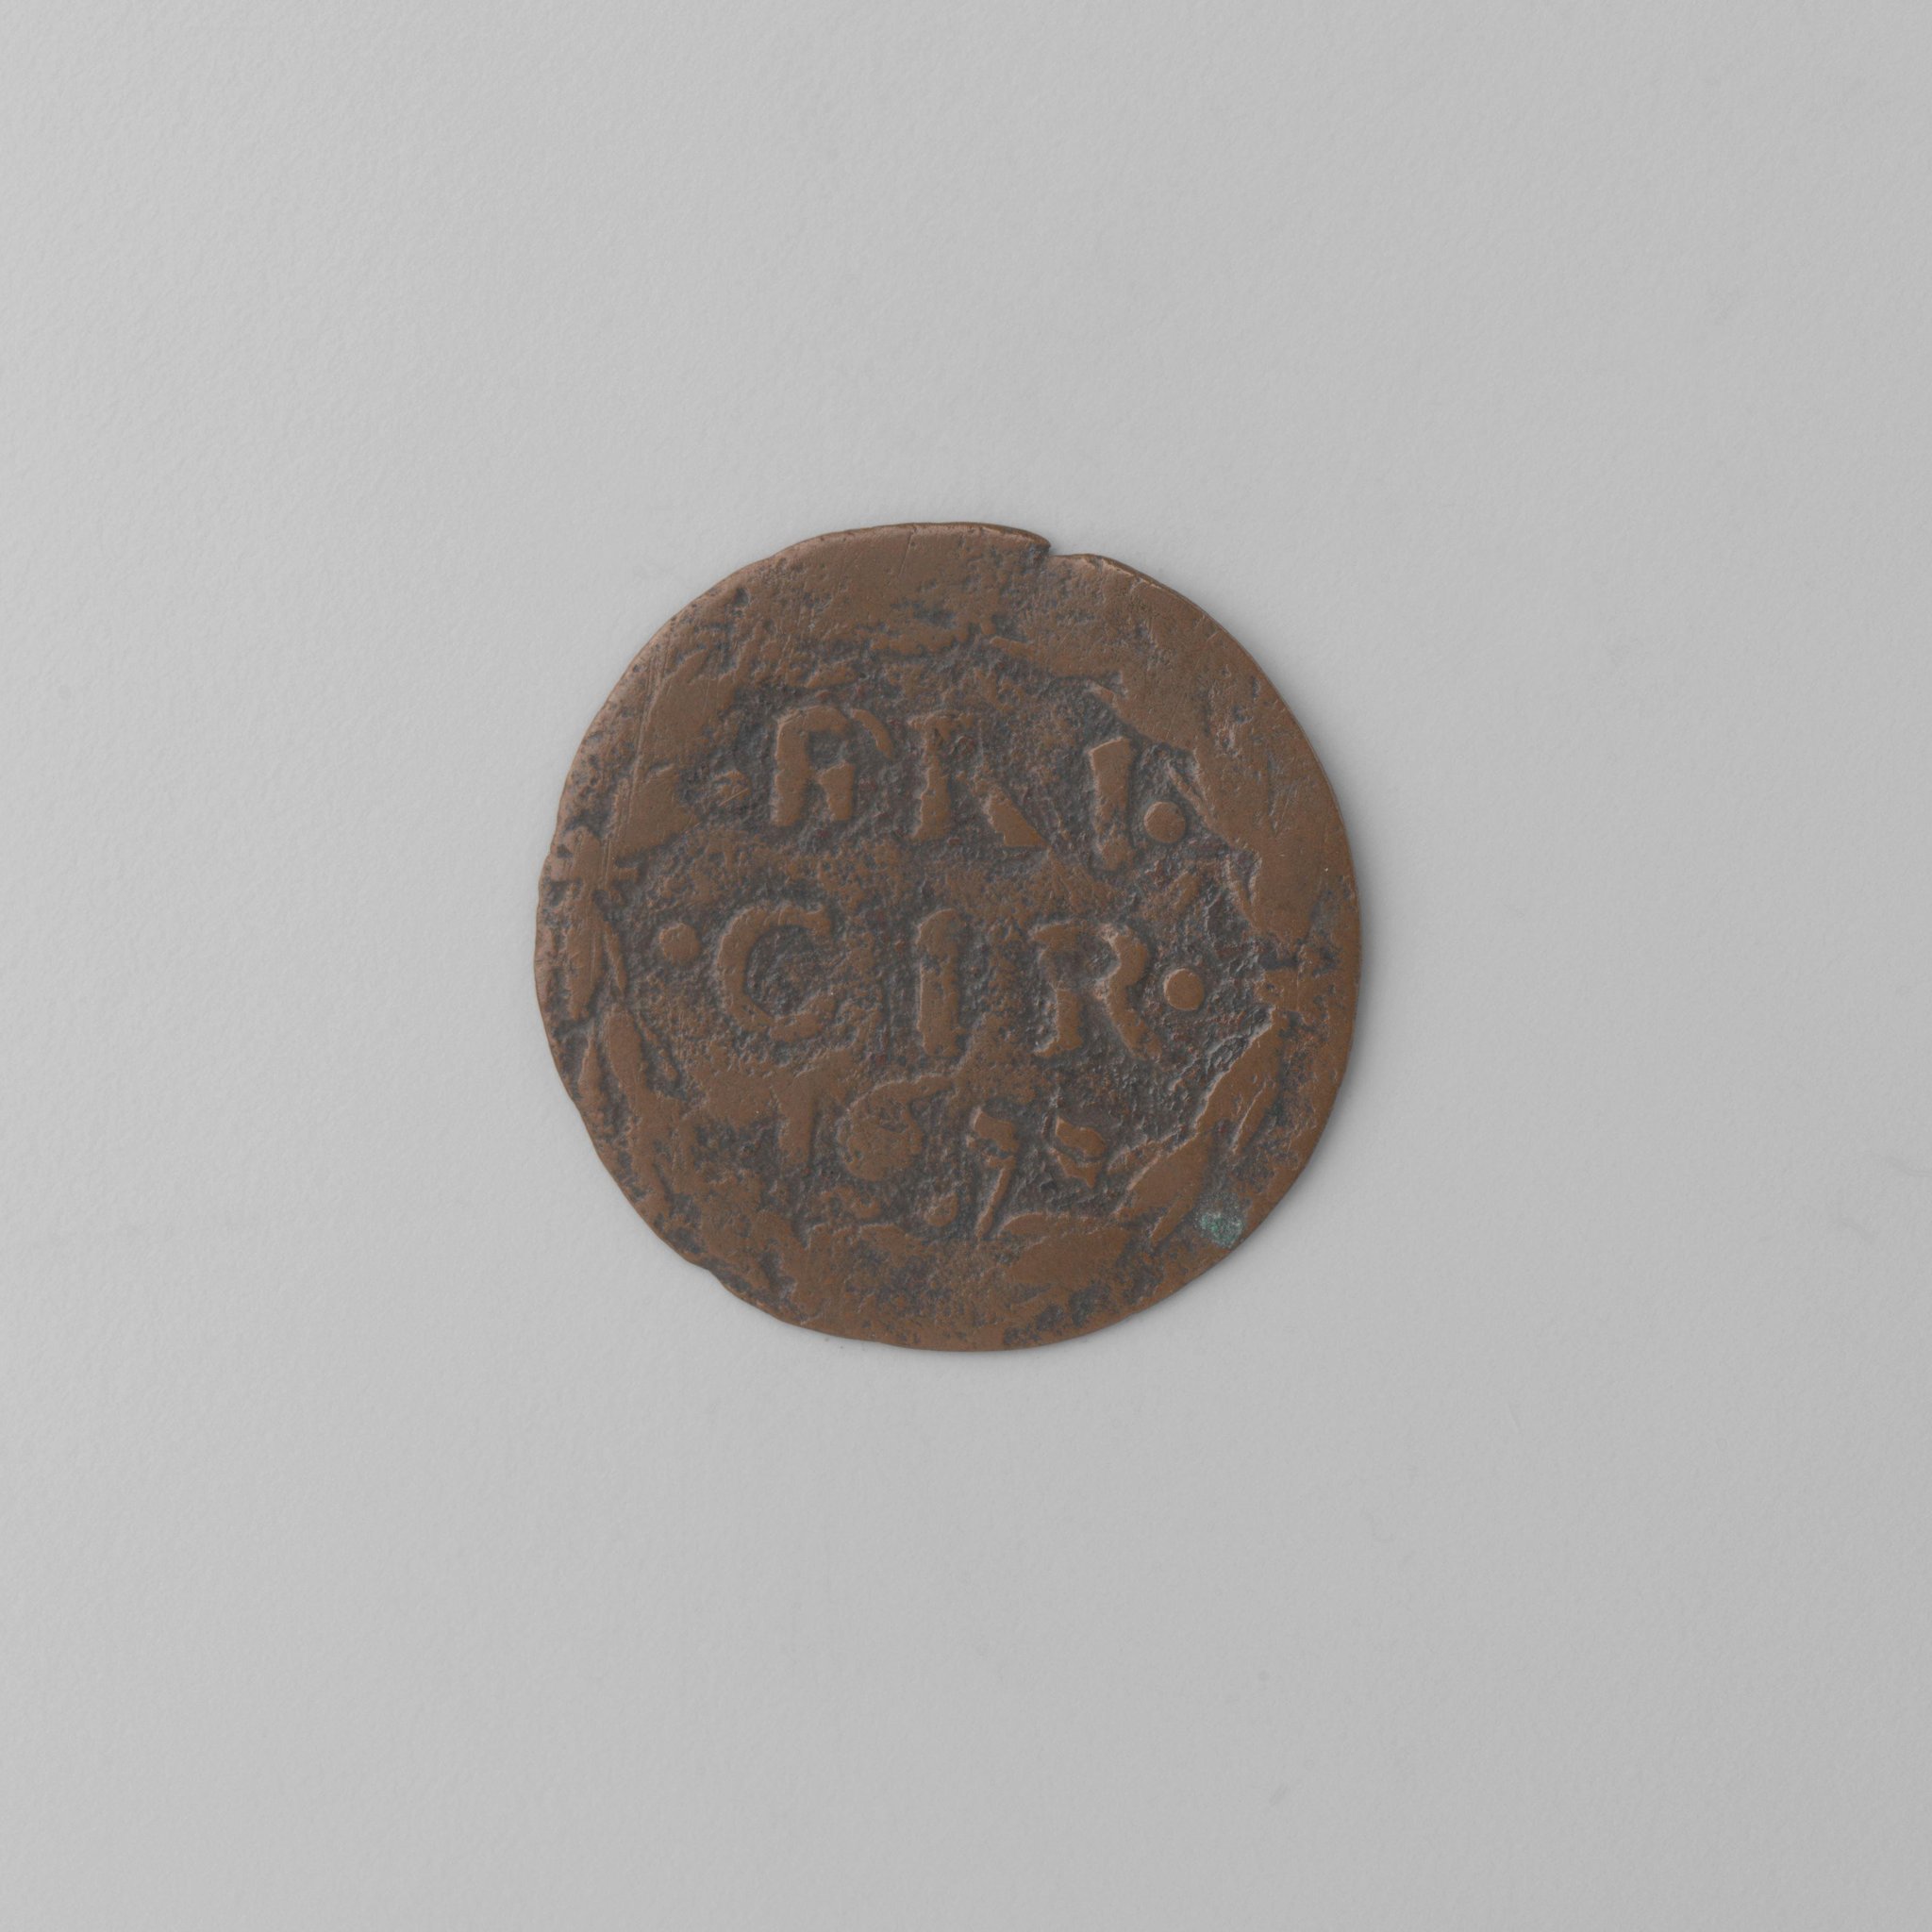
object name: coin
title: Reckheimse duit van Ferdinand van Aspremont-Lynden (1636-1665), 1633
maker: heer van reckheim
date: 1633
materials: copper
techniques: striking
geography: rekem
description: Koperen munt. Voorzijde: versierd wapenschild van Friesland, onder het schild vijf rondjes. Keerzijde: binnen een krans twee-regelig opschrift, waaronder jaartal.